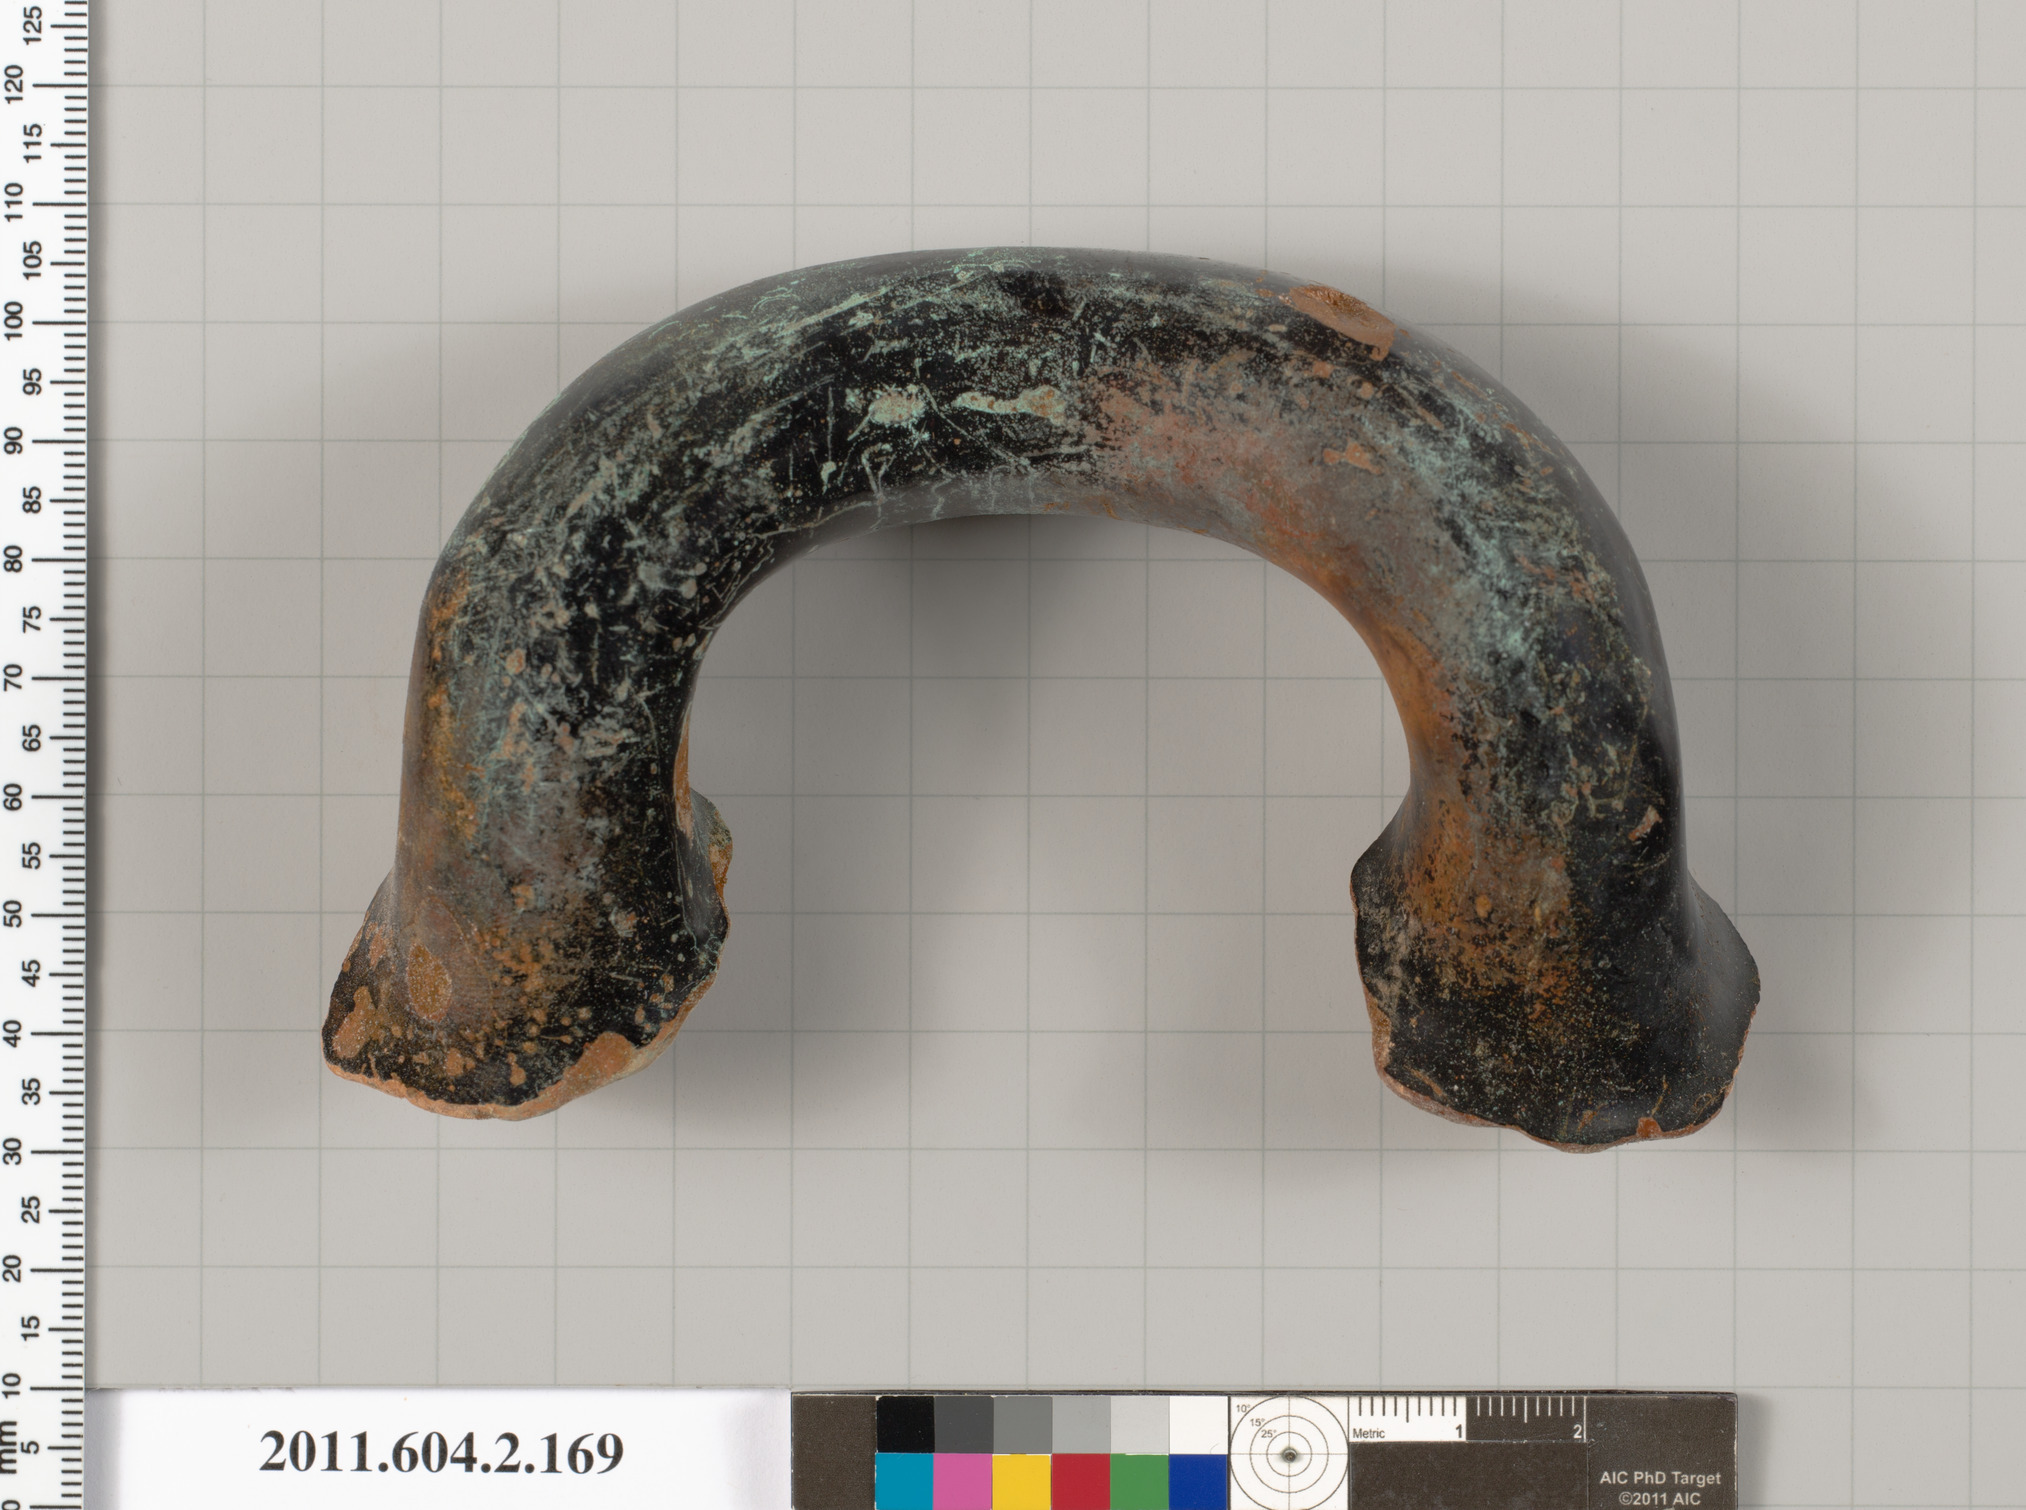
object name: stamnos fragment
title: Terracotta fragment of a stamnos (jar)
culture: greek, attic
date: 500-476 BCE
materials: terracotta